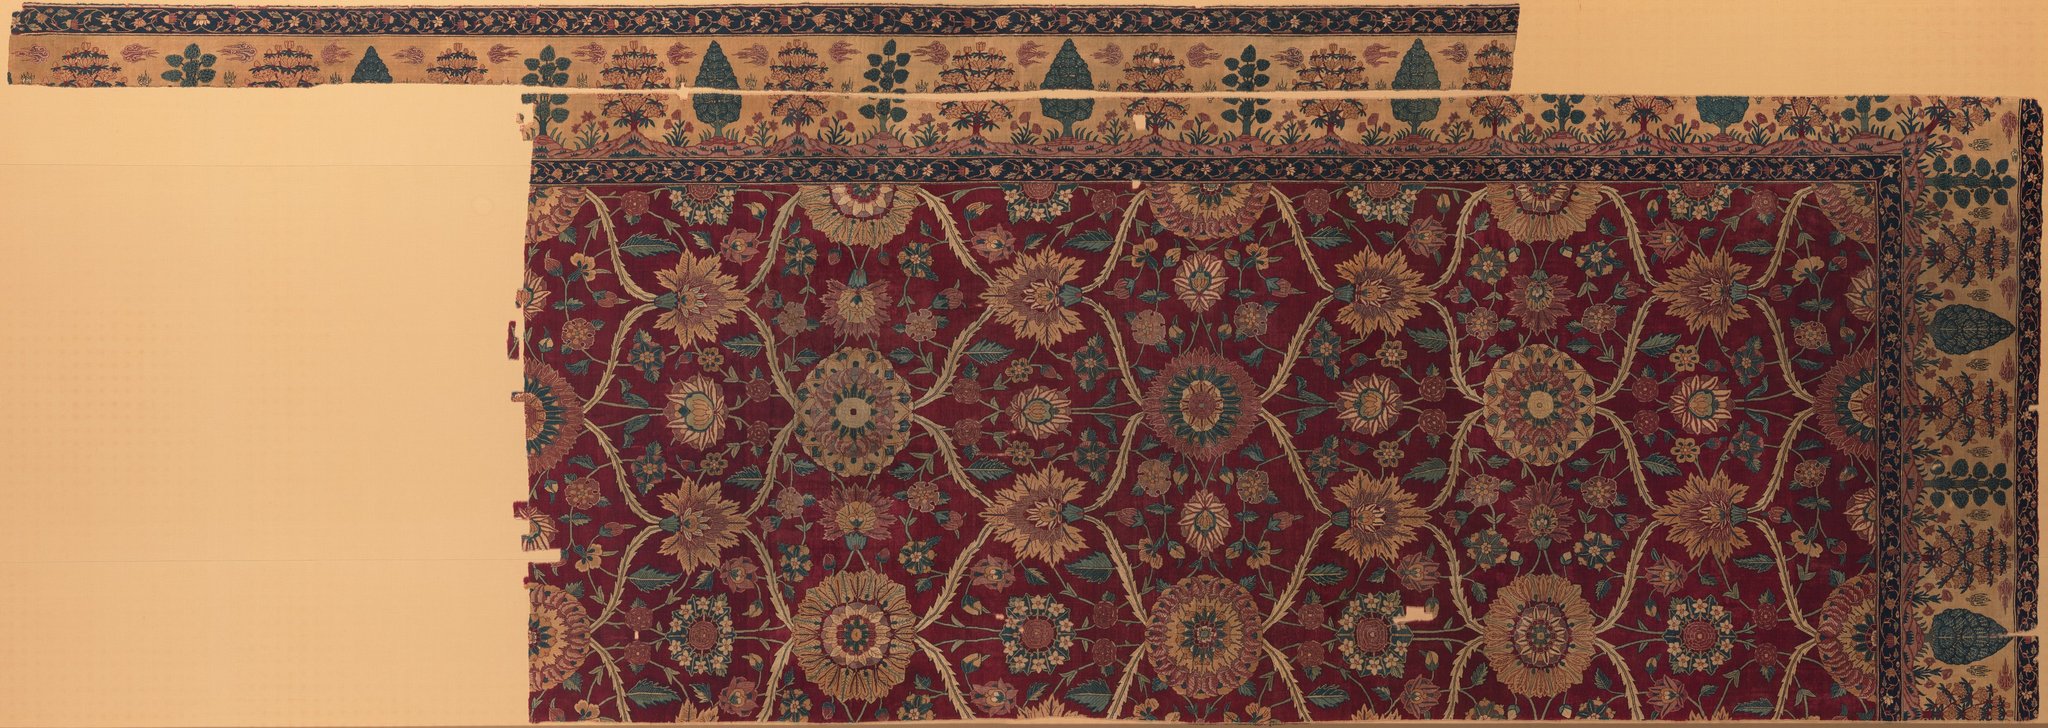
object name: carpet fragment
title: Fragments of a Carpet with Lattice and Blossom Pattern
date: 1650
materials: silk, wool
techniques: asymmetrically knotted pile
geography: india